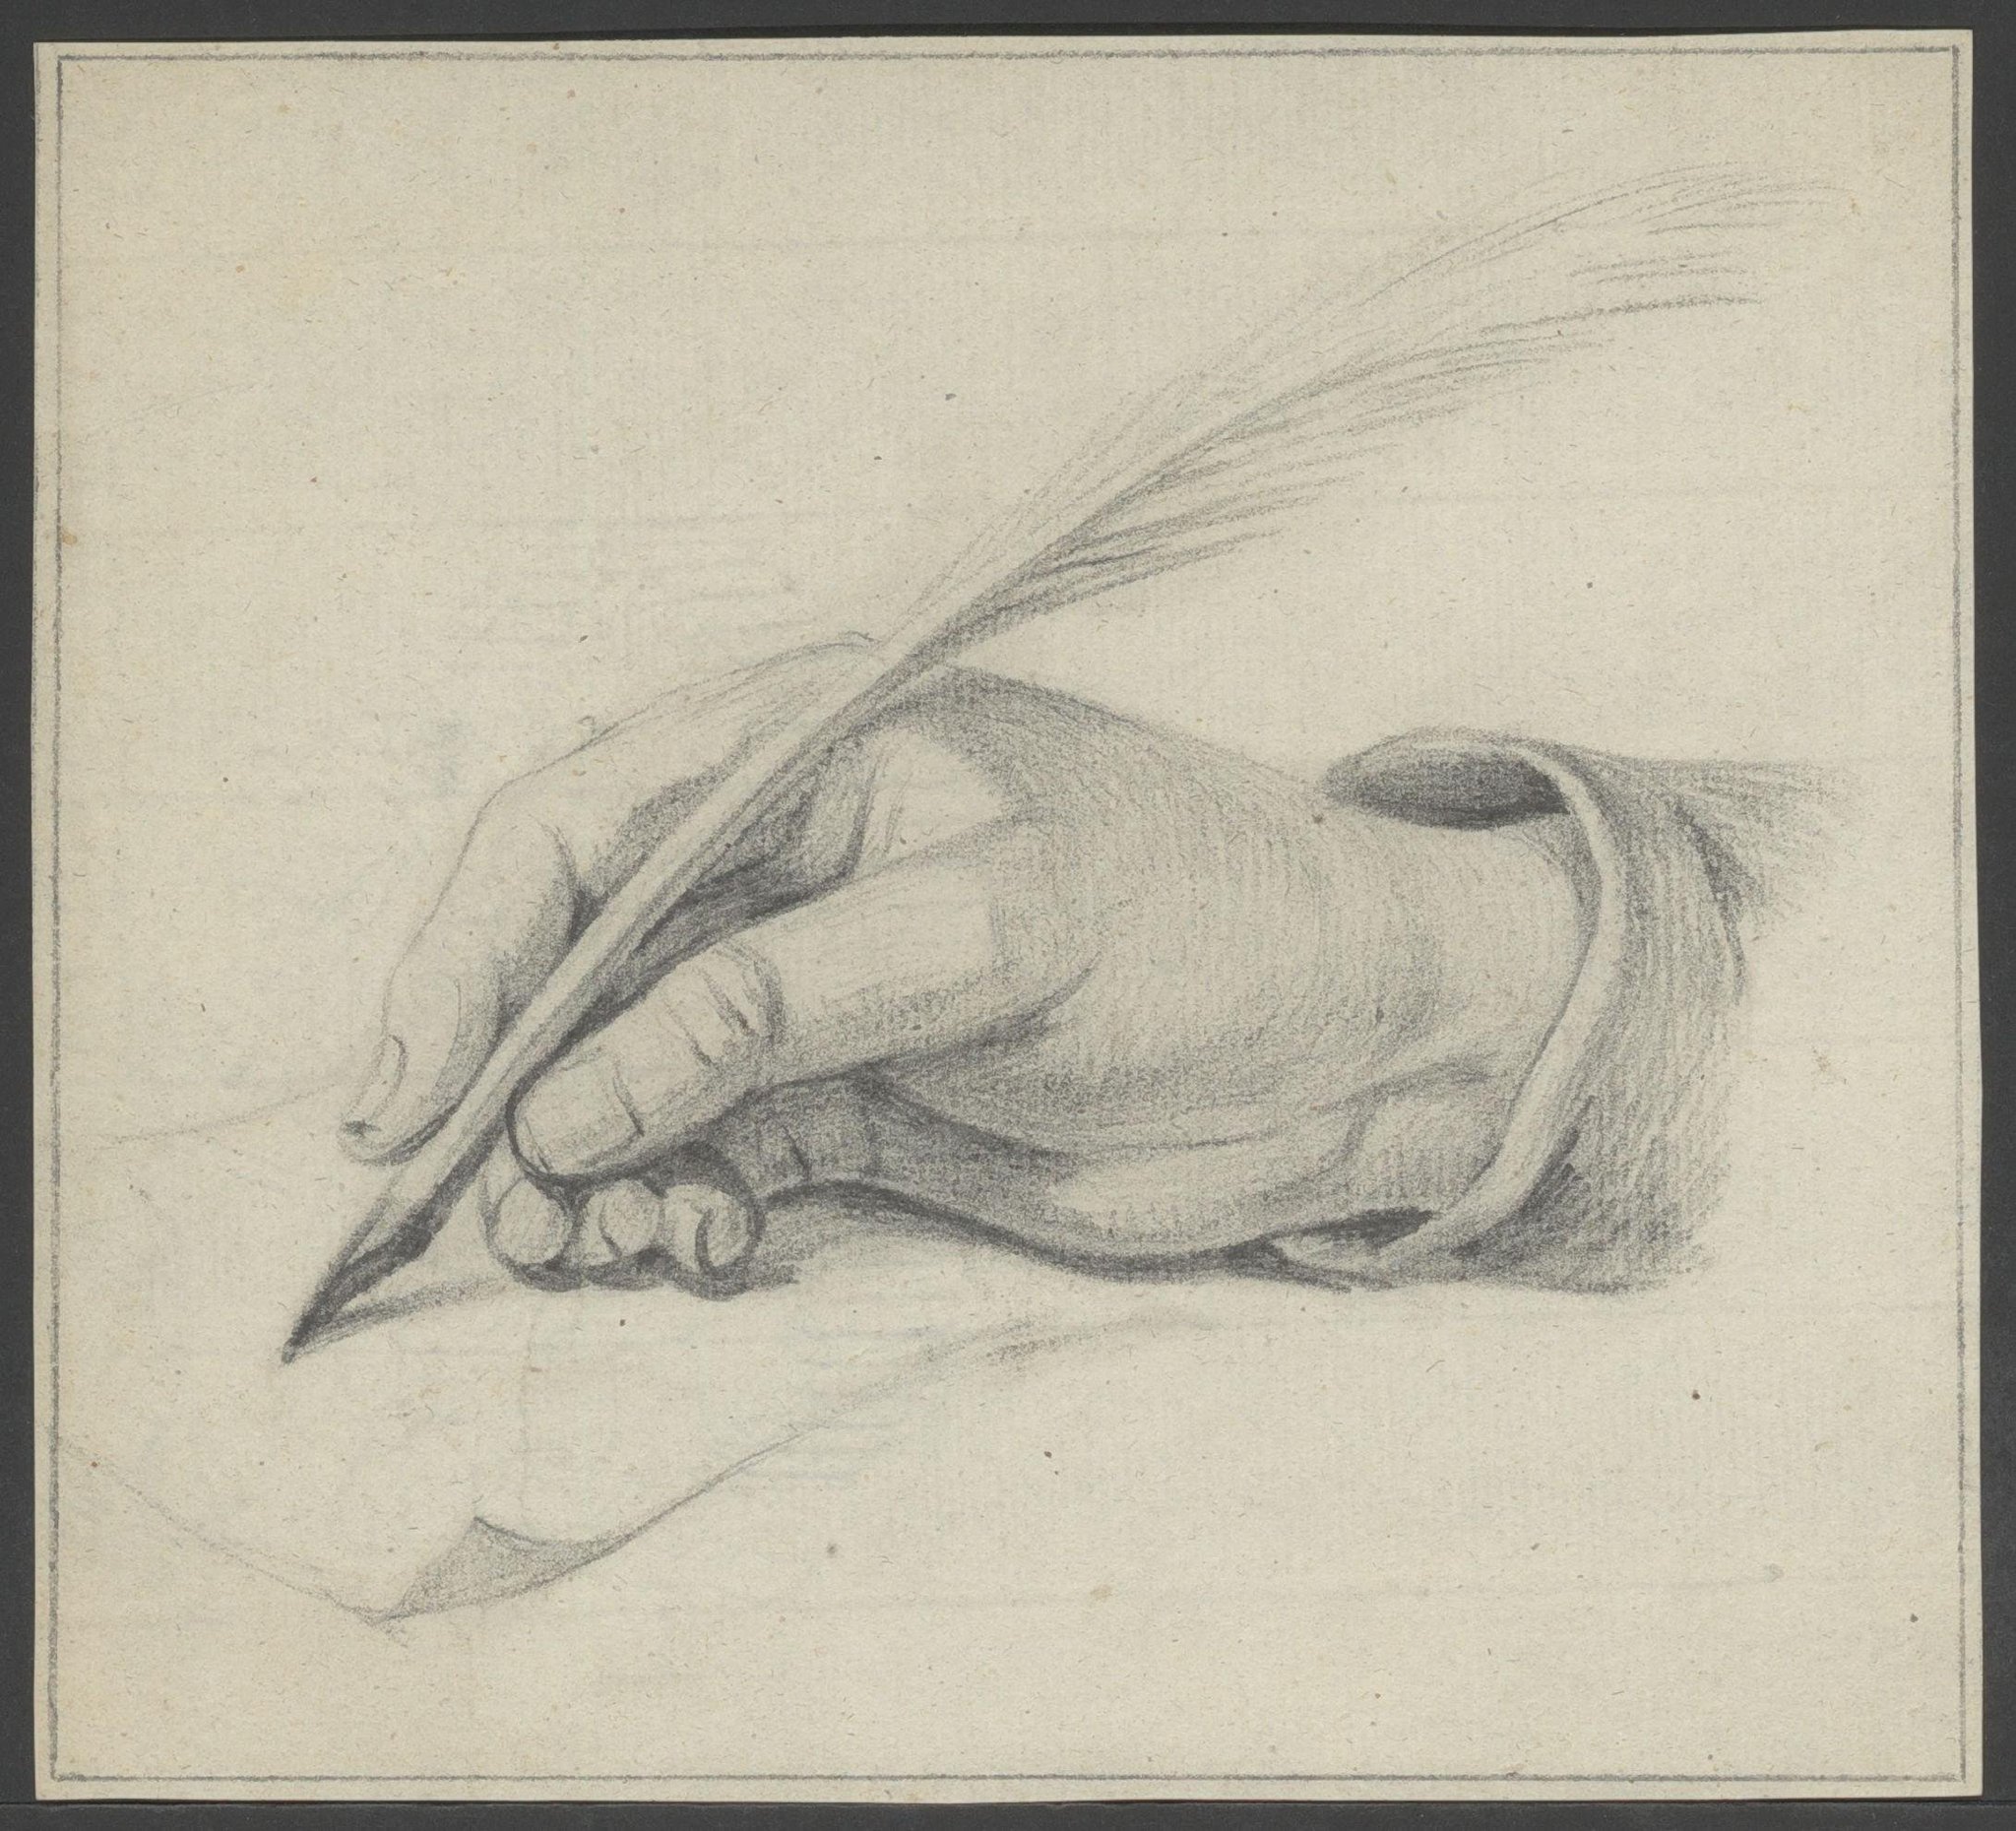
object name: drawing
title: Hand met veer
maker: jean bernard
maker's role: draughtsman, print maker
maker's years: 1765-1833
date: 1775-1833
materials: chalk, paper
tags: quill, hand, paper (writing material)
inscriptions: stamp, collector's mark: Lugt 1641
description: Onderwerpsrubrieken binnen de Atlas Zeden en Gewoonten: Schoone kunsten, Schilderkunst, Tekeningen.